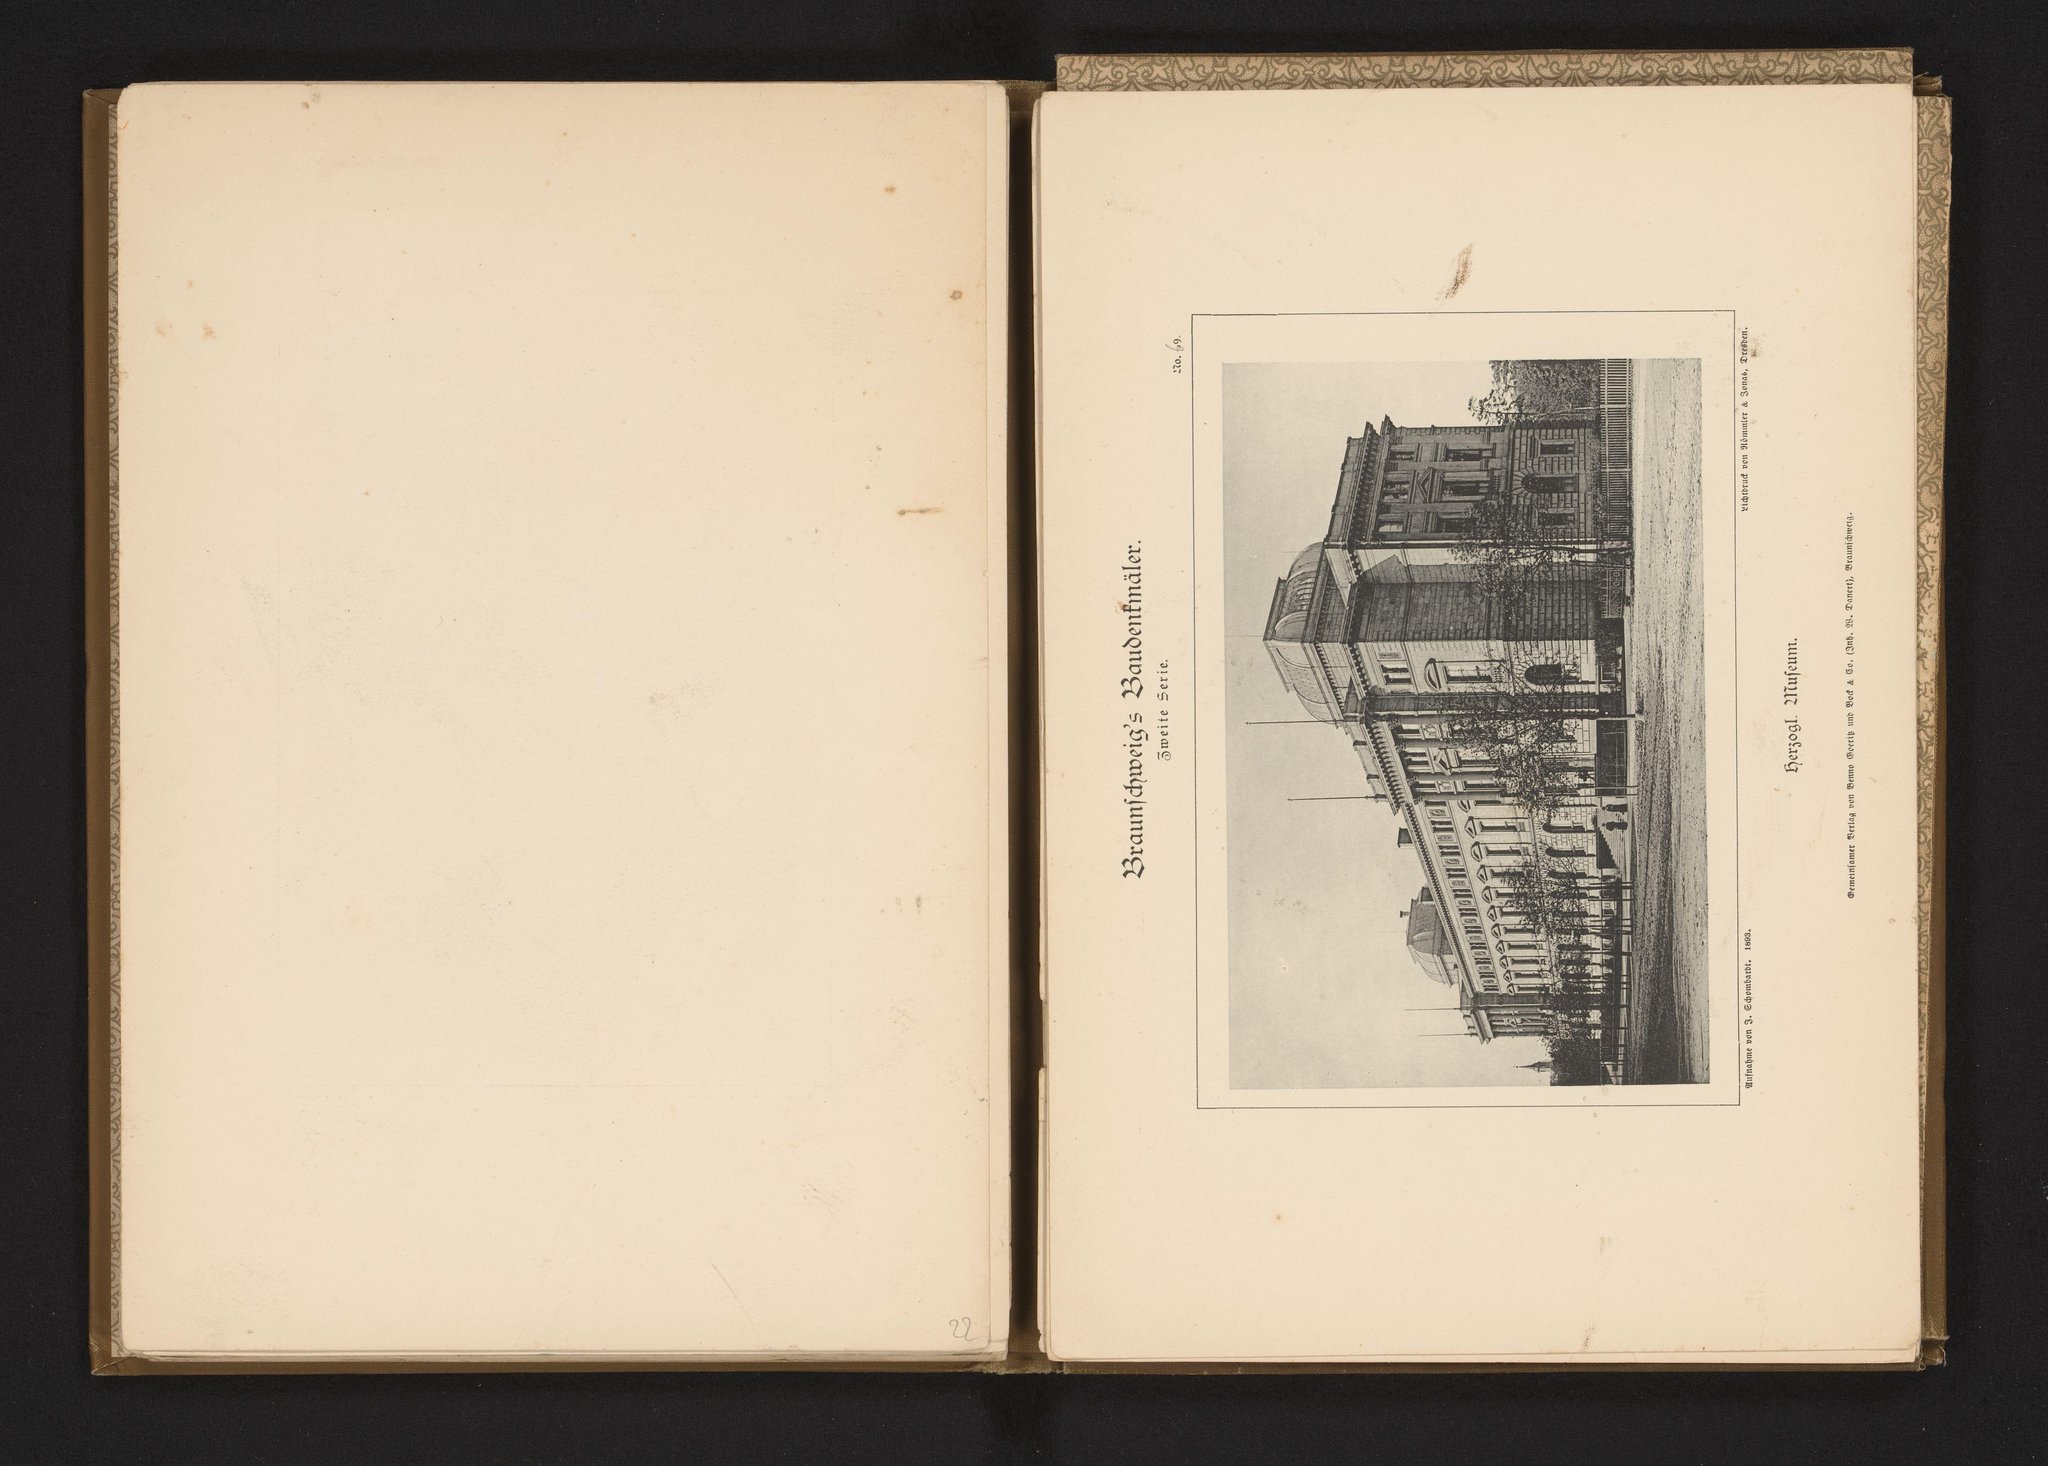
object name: photomechanical print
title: Braunschweig's Baudenkmäler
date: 1893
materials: paper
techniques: photograph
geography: dresden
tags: permanent exhibition, museum, façade (of house or building)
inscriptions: number: ‘No. 69.’